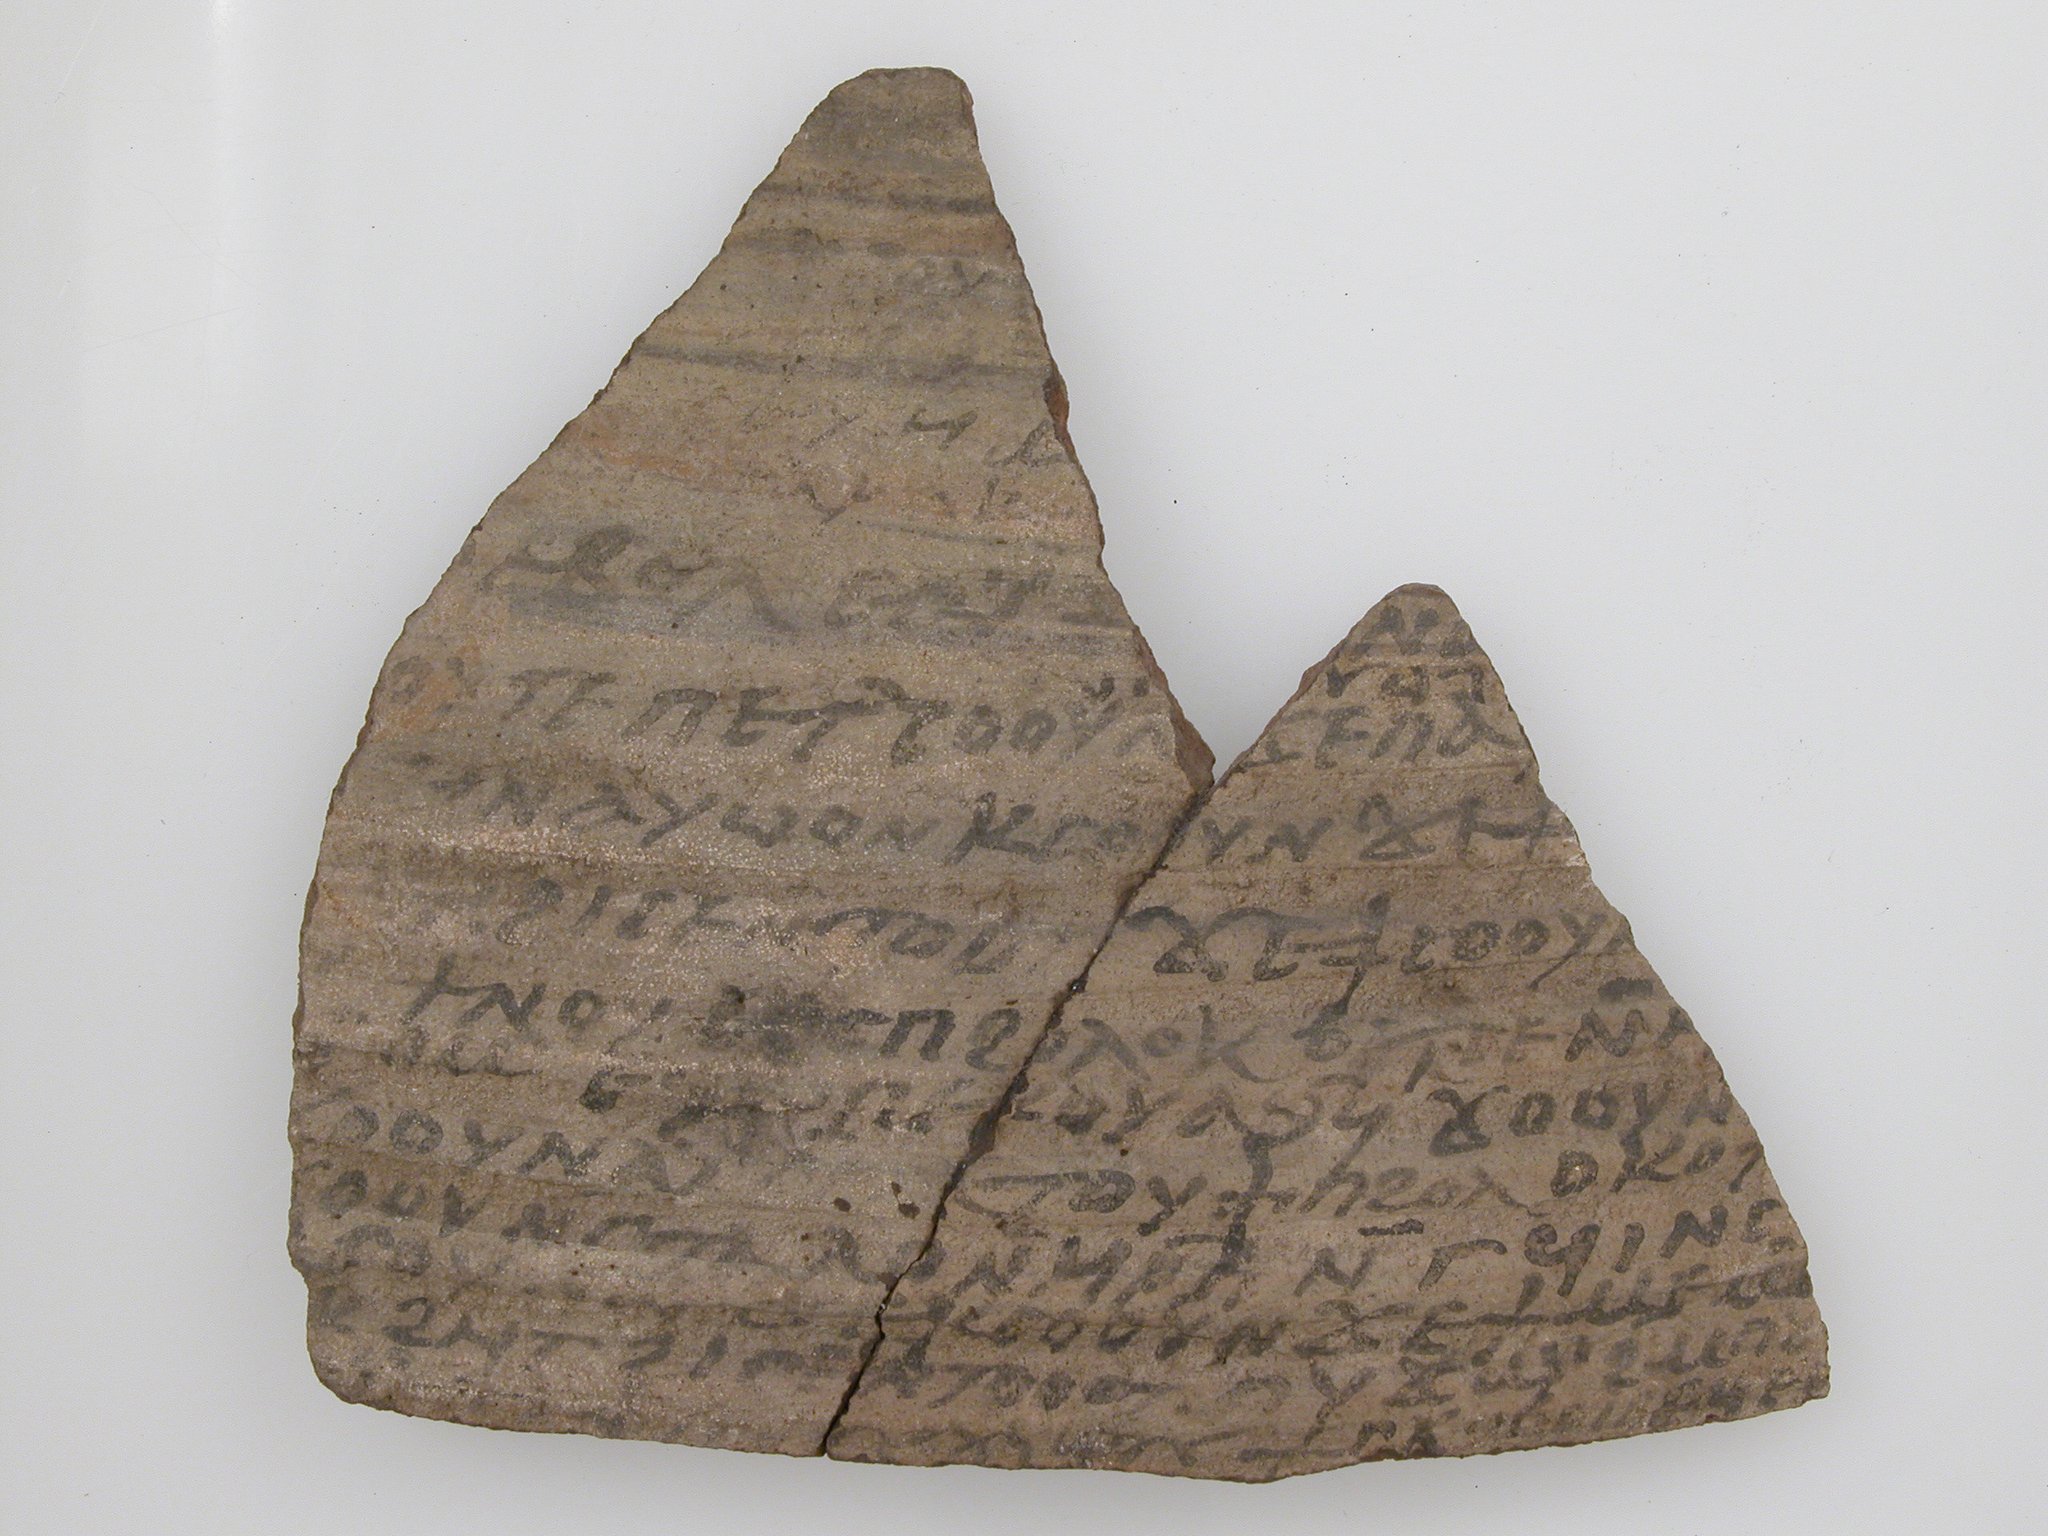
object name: ostrakon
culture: coptic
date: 601-700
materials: ink, pottery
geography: egypt